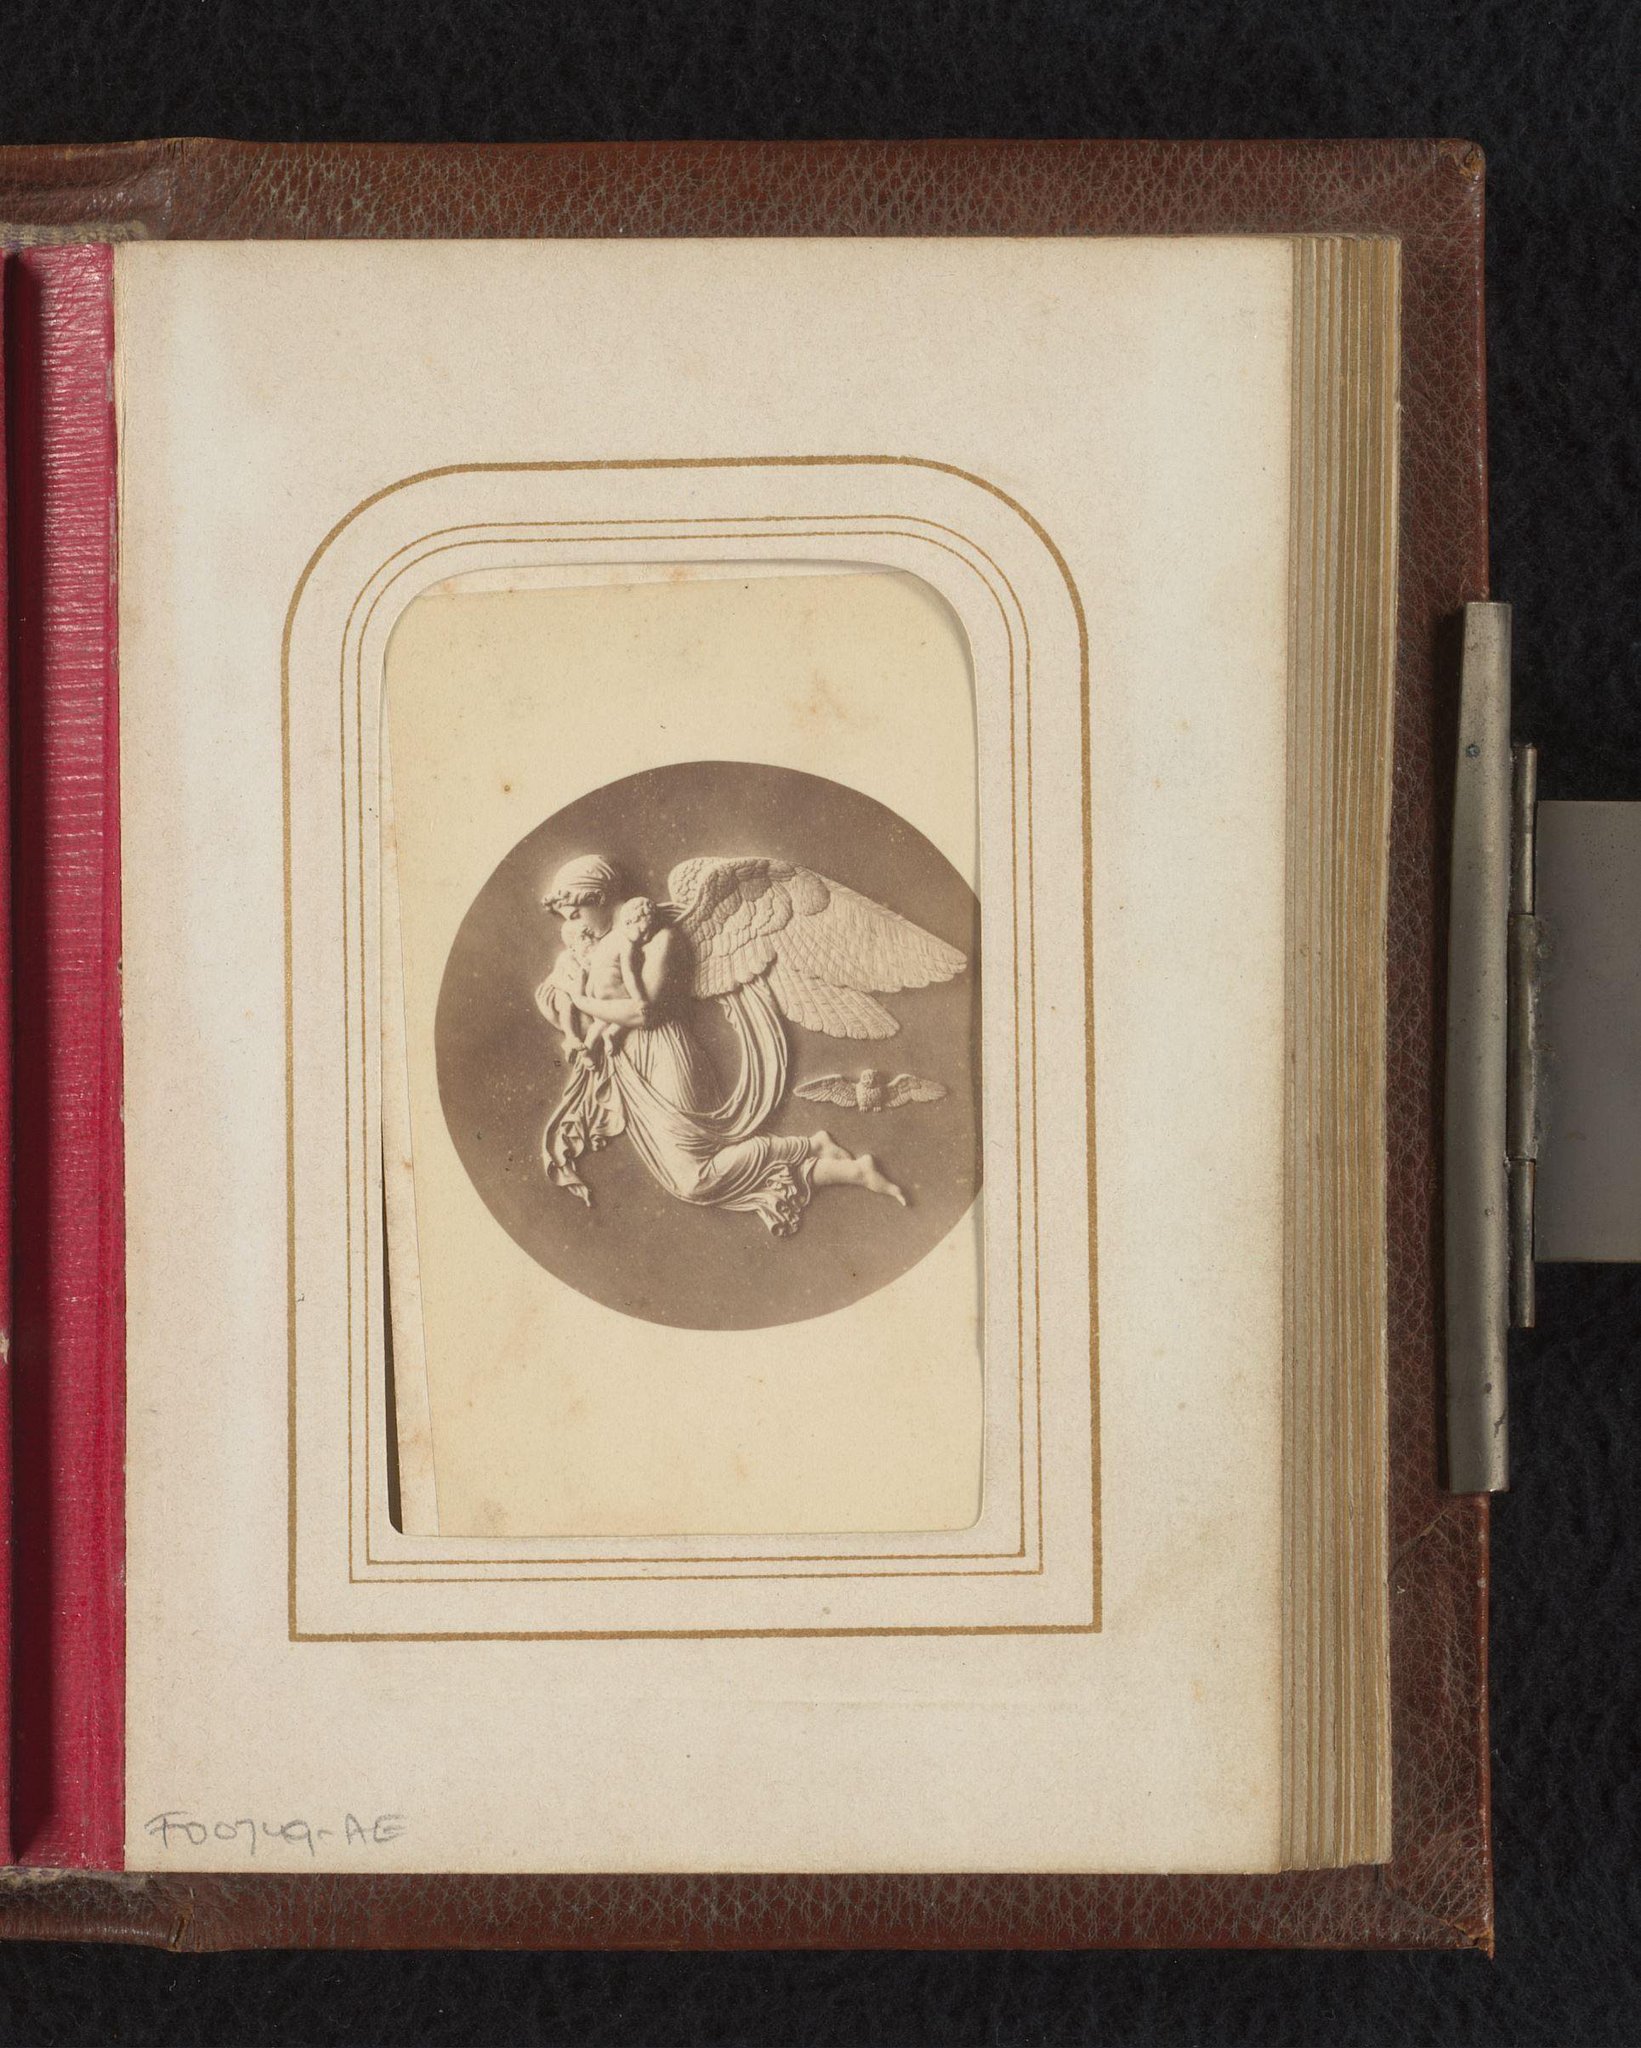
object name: carte de visite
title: Reliëf Die Nacht, ontworpen door Bertel Thorvaldsen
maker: Anonymous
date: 1865-1900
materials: cardboard, photographic support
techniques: albumen print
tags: night, sculpture (+ relief ~ sculpture)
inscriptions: inscription: ‘Die Nacht nach Thorwaldsen/ 503.’